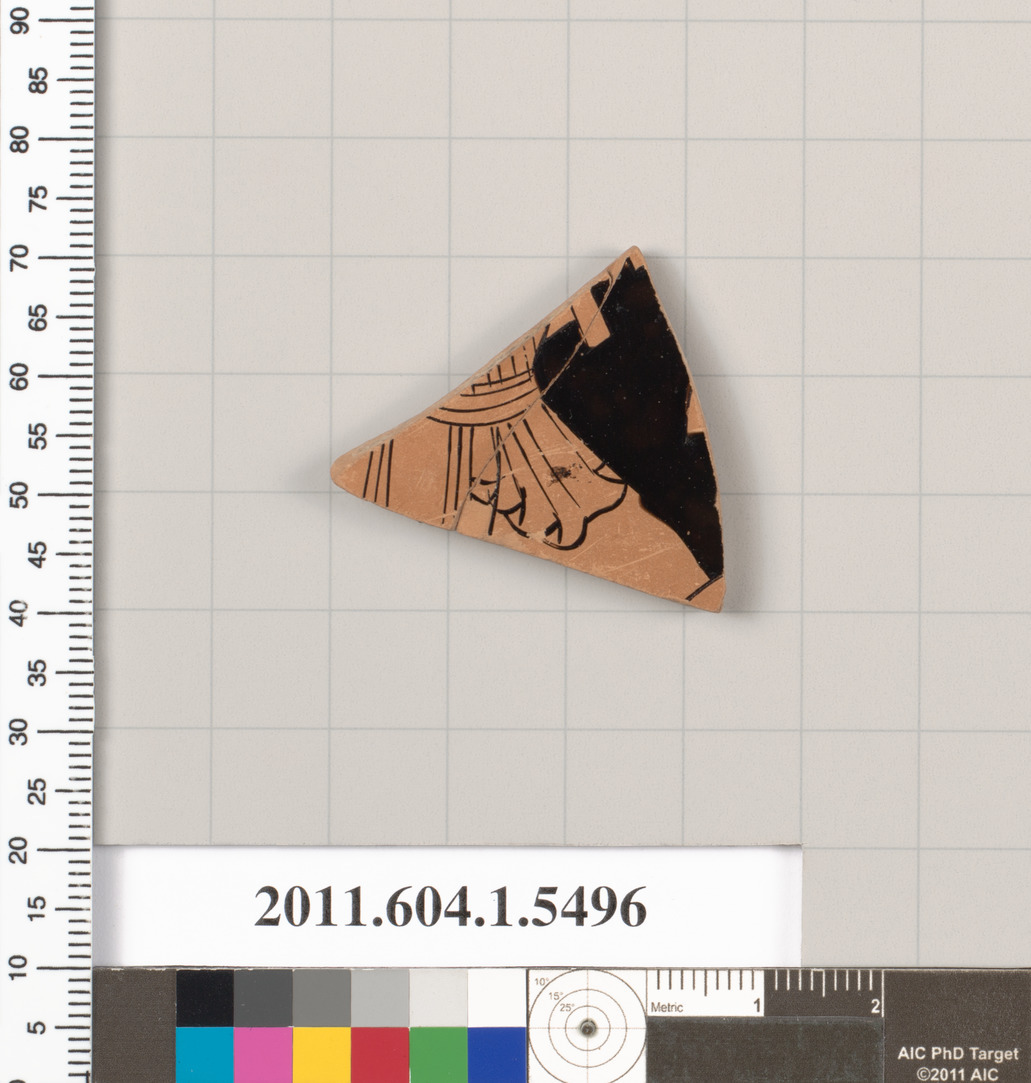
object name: kylix fragment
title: Terracotta fragment of a kylix (drinking cup)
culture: greek, attic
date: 490-480 BCE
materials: terracotta